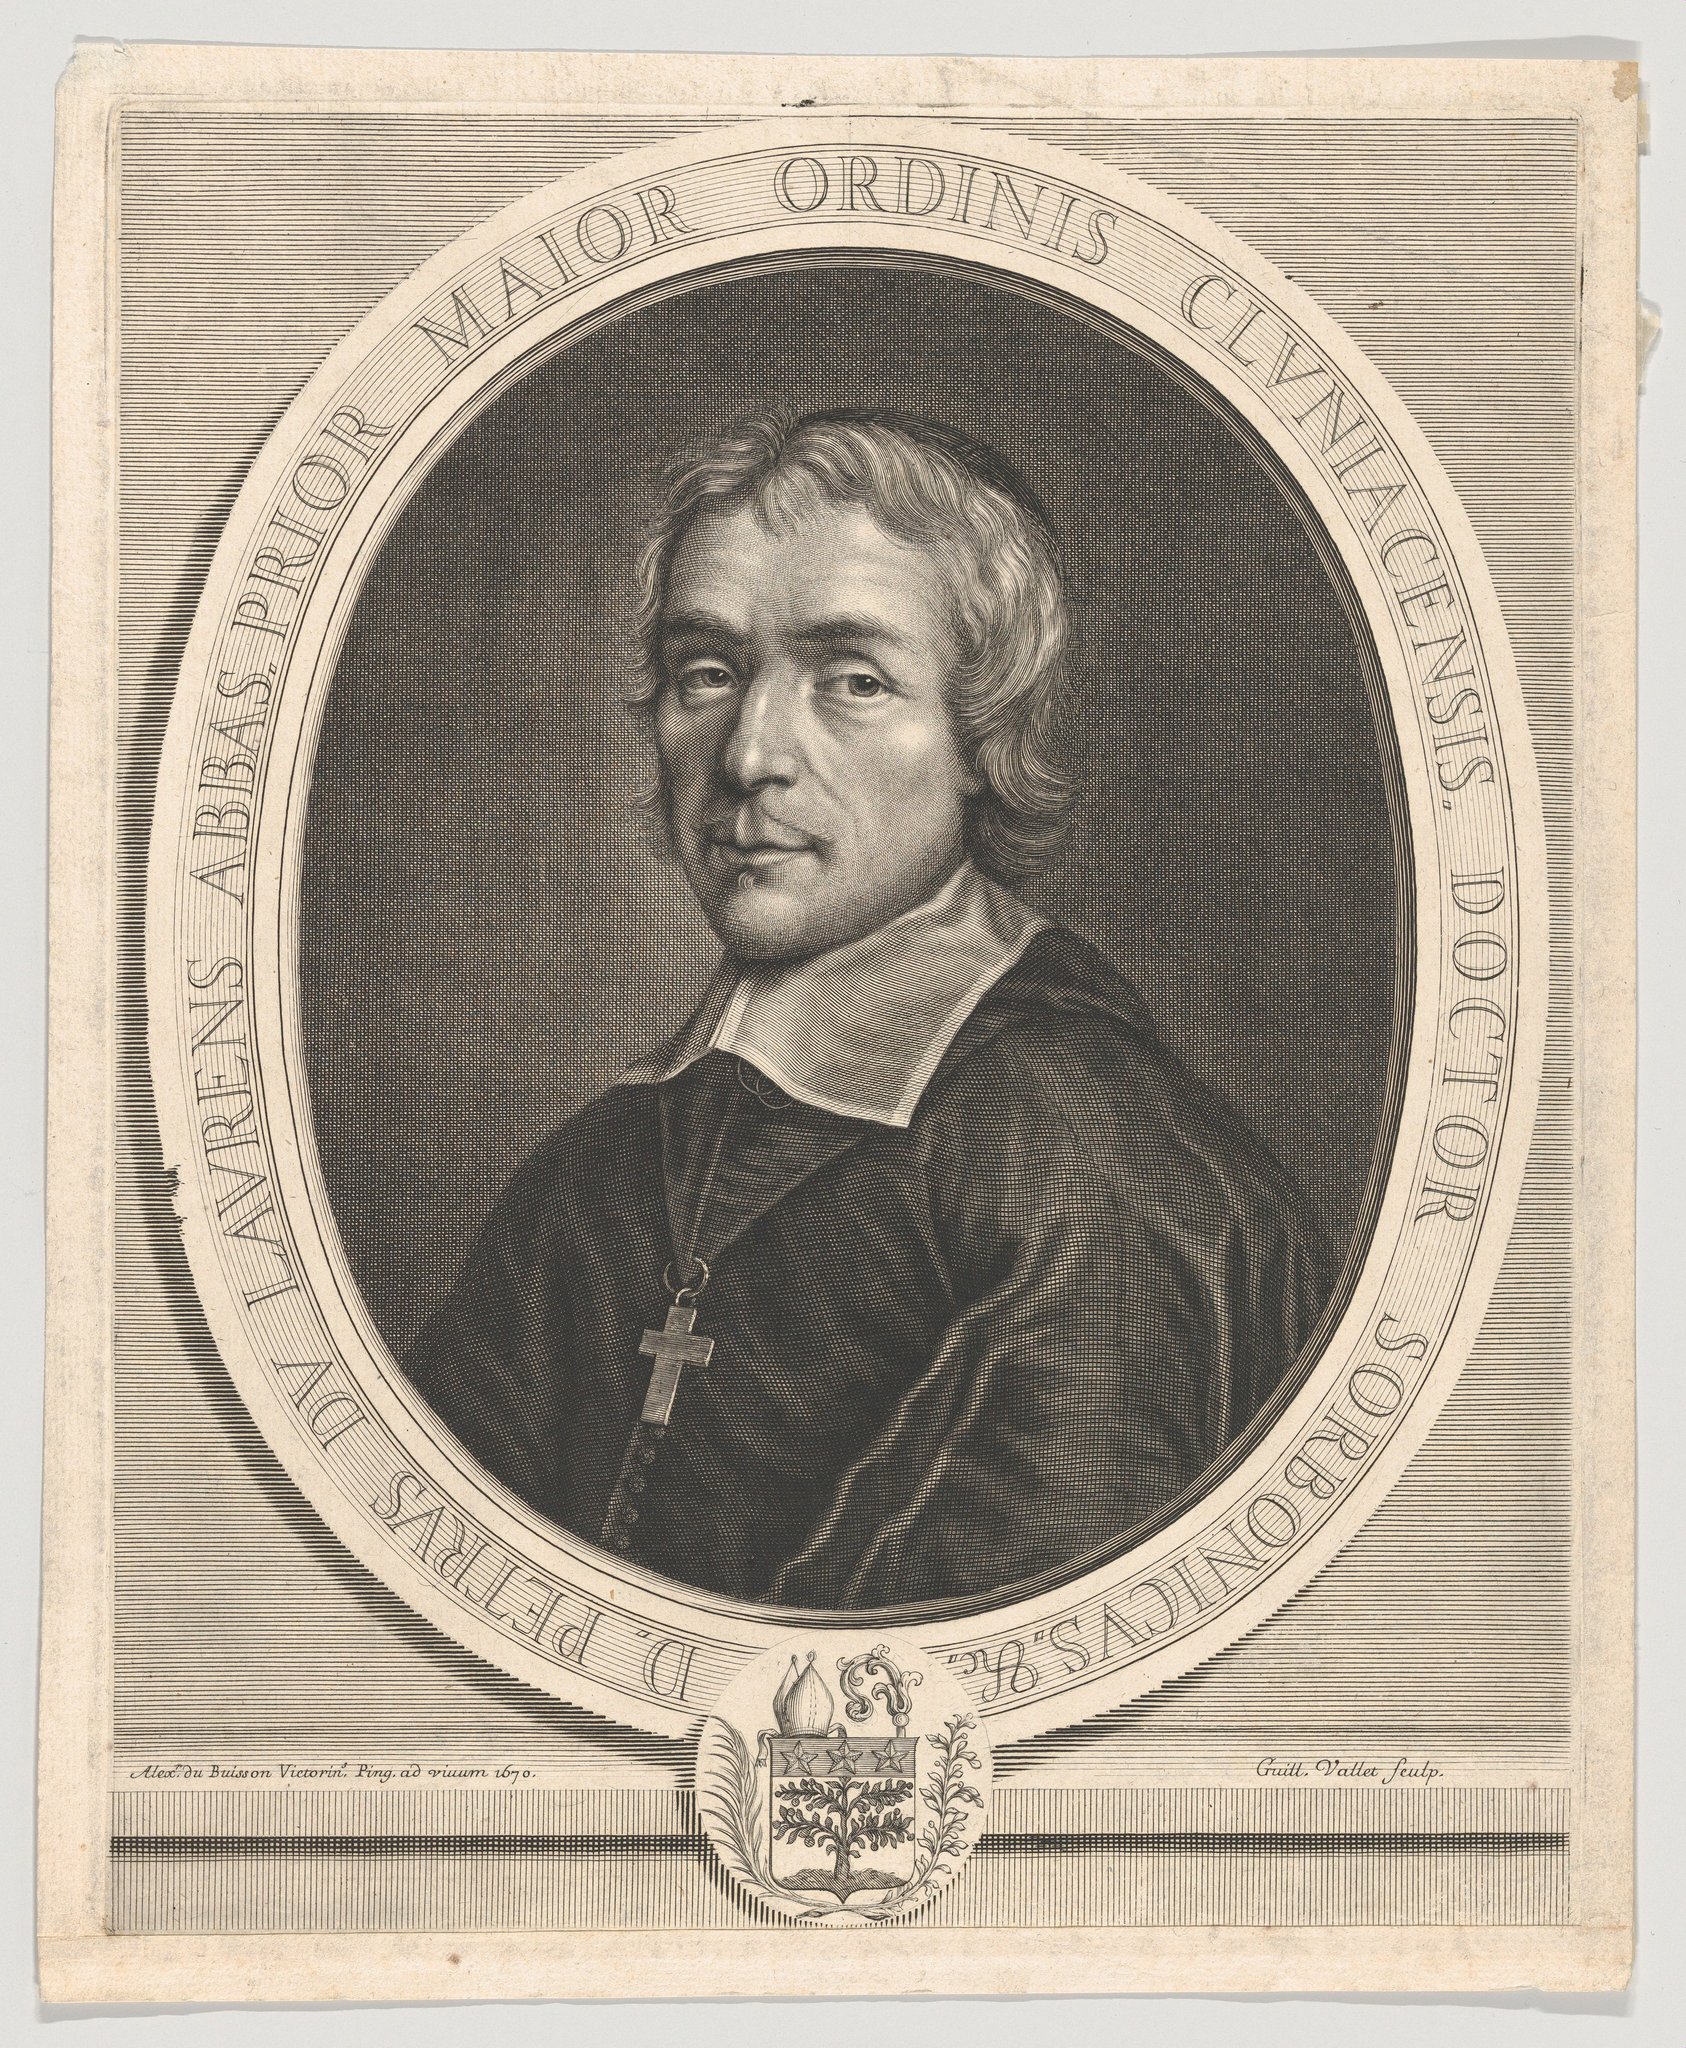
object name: print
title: Portrait of Pierre du Laurens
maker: guillaume vallet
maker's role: engraver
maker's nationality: french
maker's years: 1632-1704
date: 1670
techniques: engraving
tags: men,portraits